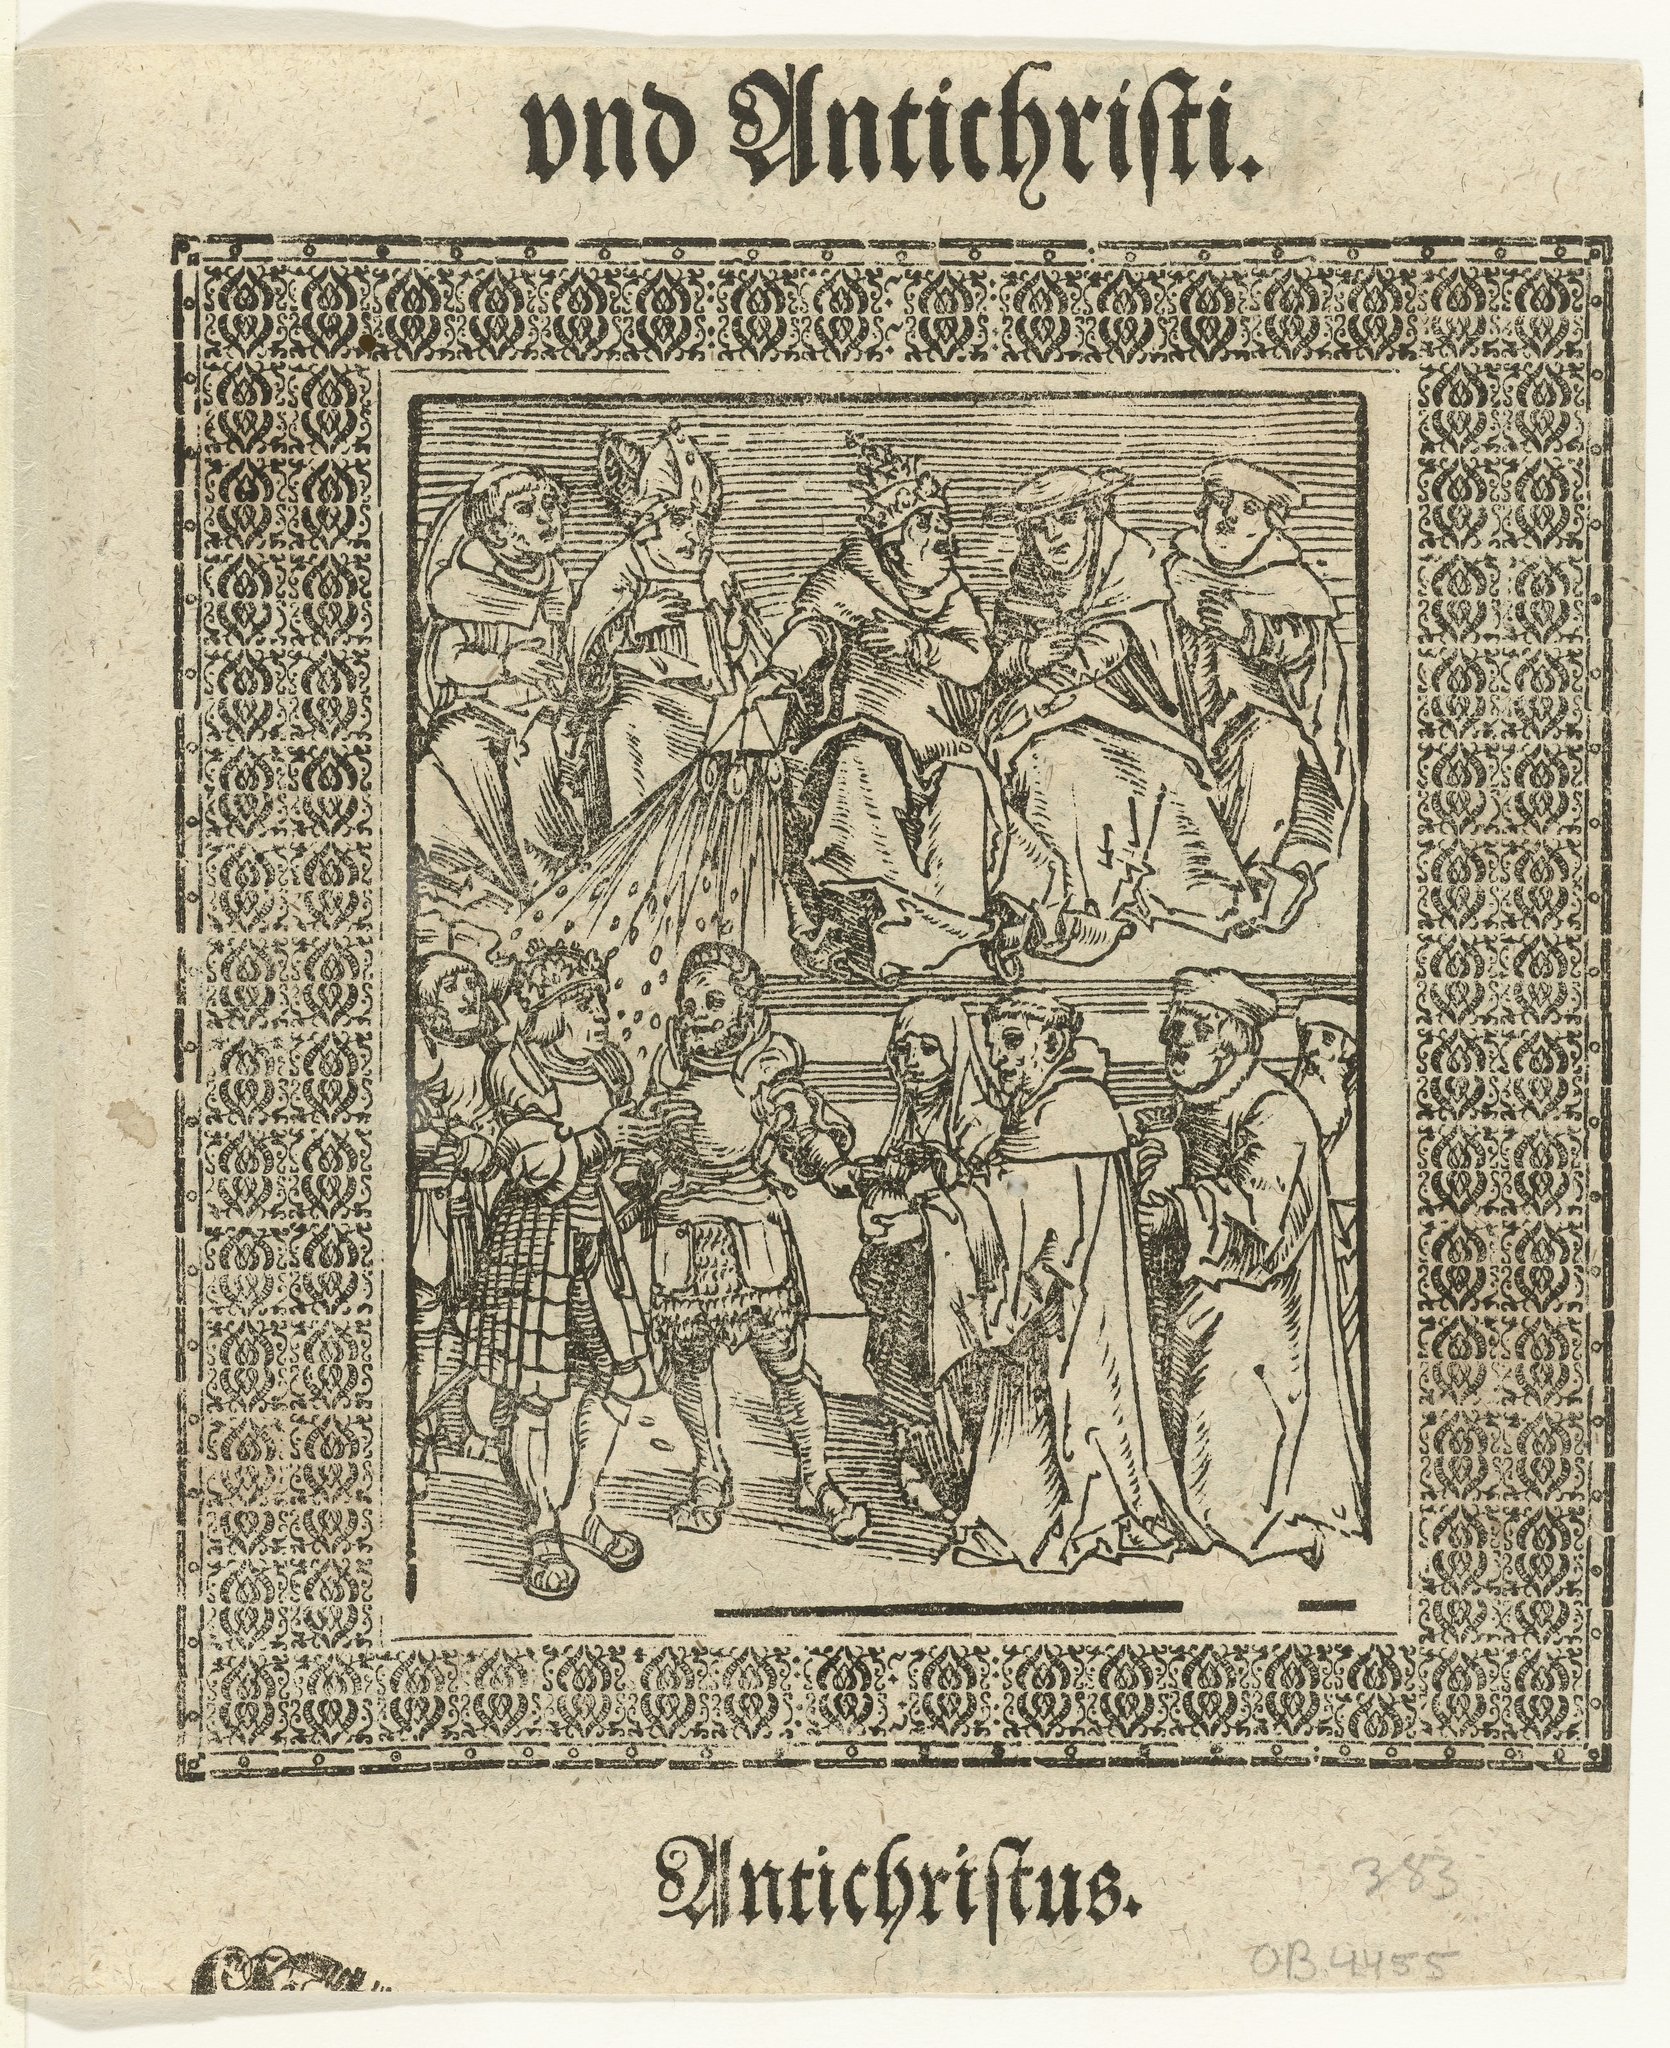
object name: print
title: Paus spreekt banvloek uit over keizer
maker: lucas cranach (i)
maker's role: draughtsman, print maker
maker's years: 1472-1553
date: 1521-1522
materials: paper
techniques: woodcut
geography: wittenberg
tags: archbishop, bishop, etc. (roman catholic), representants of the church (christians in general, laymen, monks, etc.) in strife with each other or with opponents, pope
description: De tegenhanger van deze prent is in deze uitgave de voorstelling Wonderbare visvangst op het meer van Galilee, zie RP-P-OB-4454(R). Blad uit: Passional Christi und Antichristi, Wittenberg 1521-1522, Johann Grünenberg. In 1521-1522 verschenen veel verschillende uitgaven van dit populaire werk van Maarten Luther. In de collectie van het RMA bevindt zich de complete serie van zesentwintig afbeeldingen uit een van deze uitgaven. De pagina's zijn op een kleiner formaat gesneden, onder iedere voorstelling stond oorspronkelijk een aantal regels Duitse tekst. De bladen hebben allemaal op dezelfde plaats twee kleine gaatjes van vraat door ongedierte wat er op wijst dat ze behoren tot hetzelfde exemplaar.